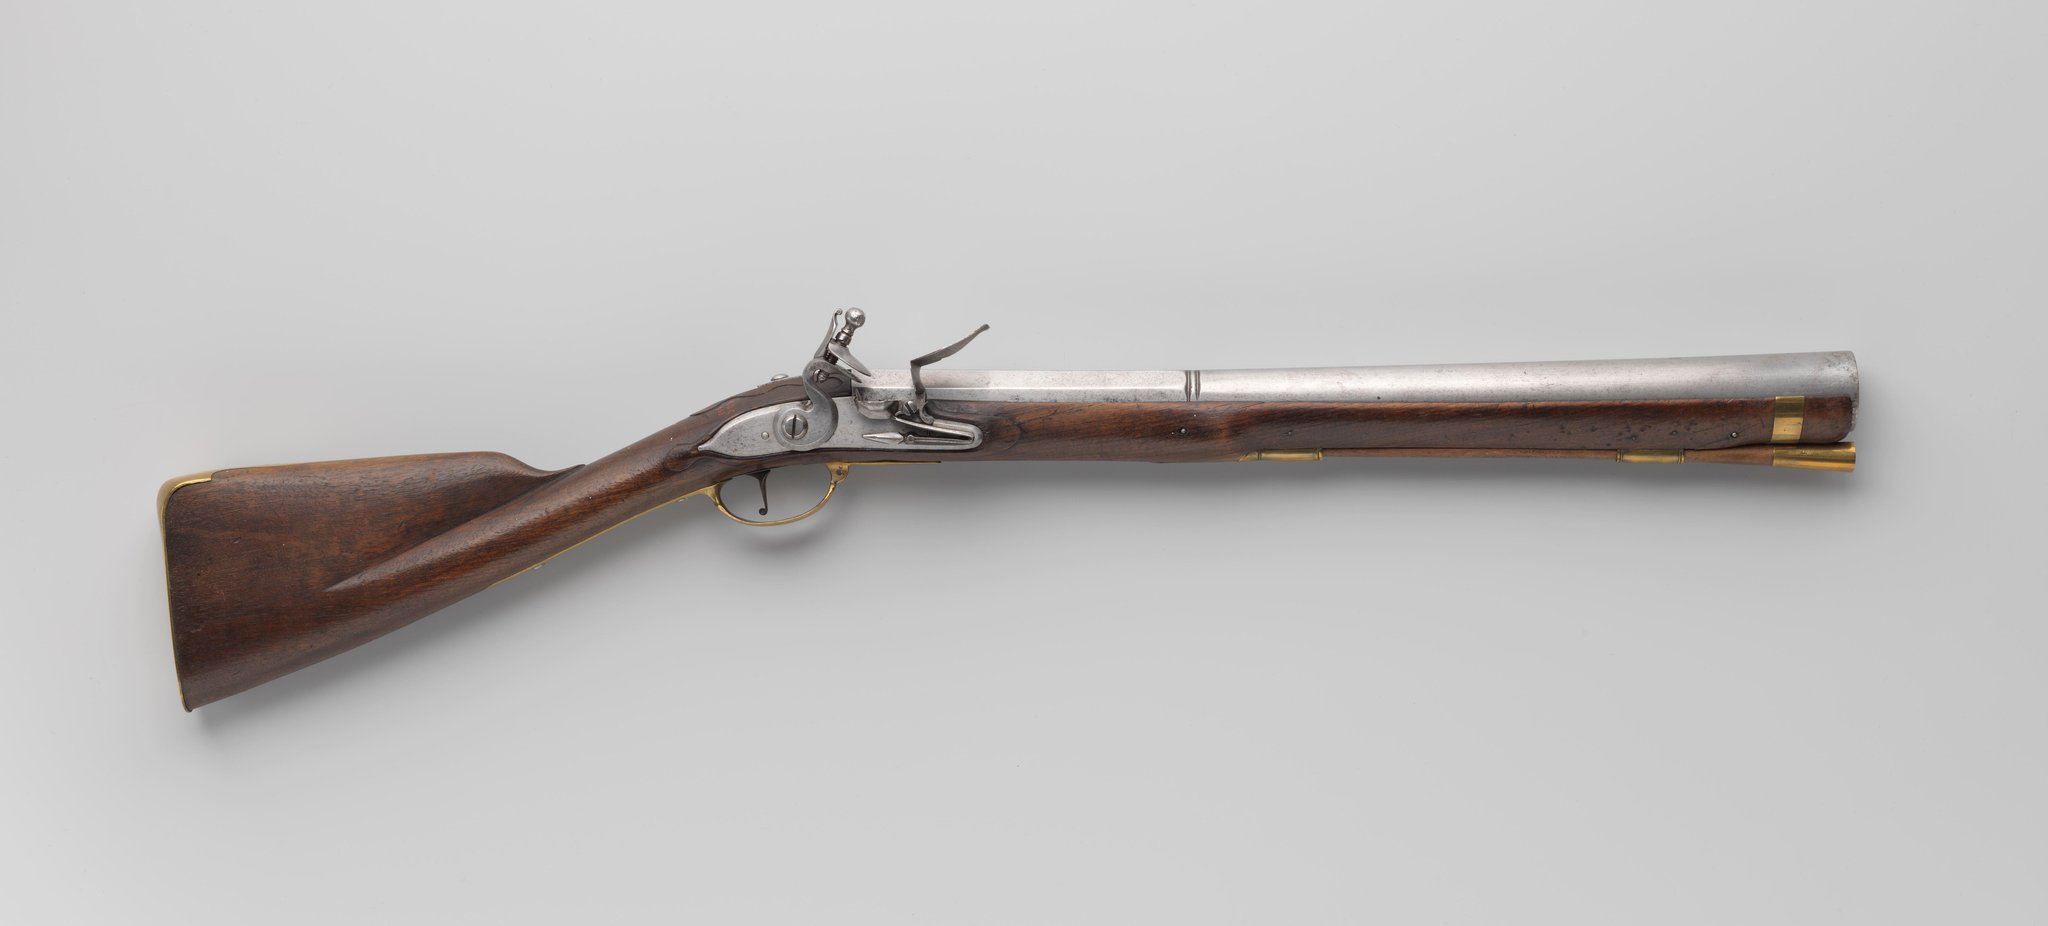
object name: spreidloopwapen, donderbus, blunderbus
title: Donderbus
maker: Anonymous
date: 1700-1900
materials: copper, iron, wood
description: Donderbus met steenslot, loop deels rond, deels achtkantig. Kolf met koper beslagen. Laadstok ontbreekt. Bovenop loop merkteken Amsterdam.